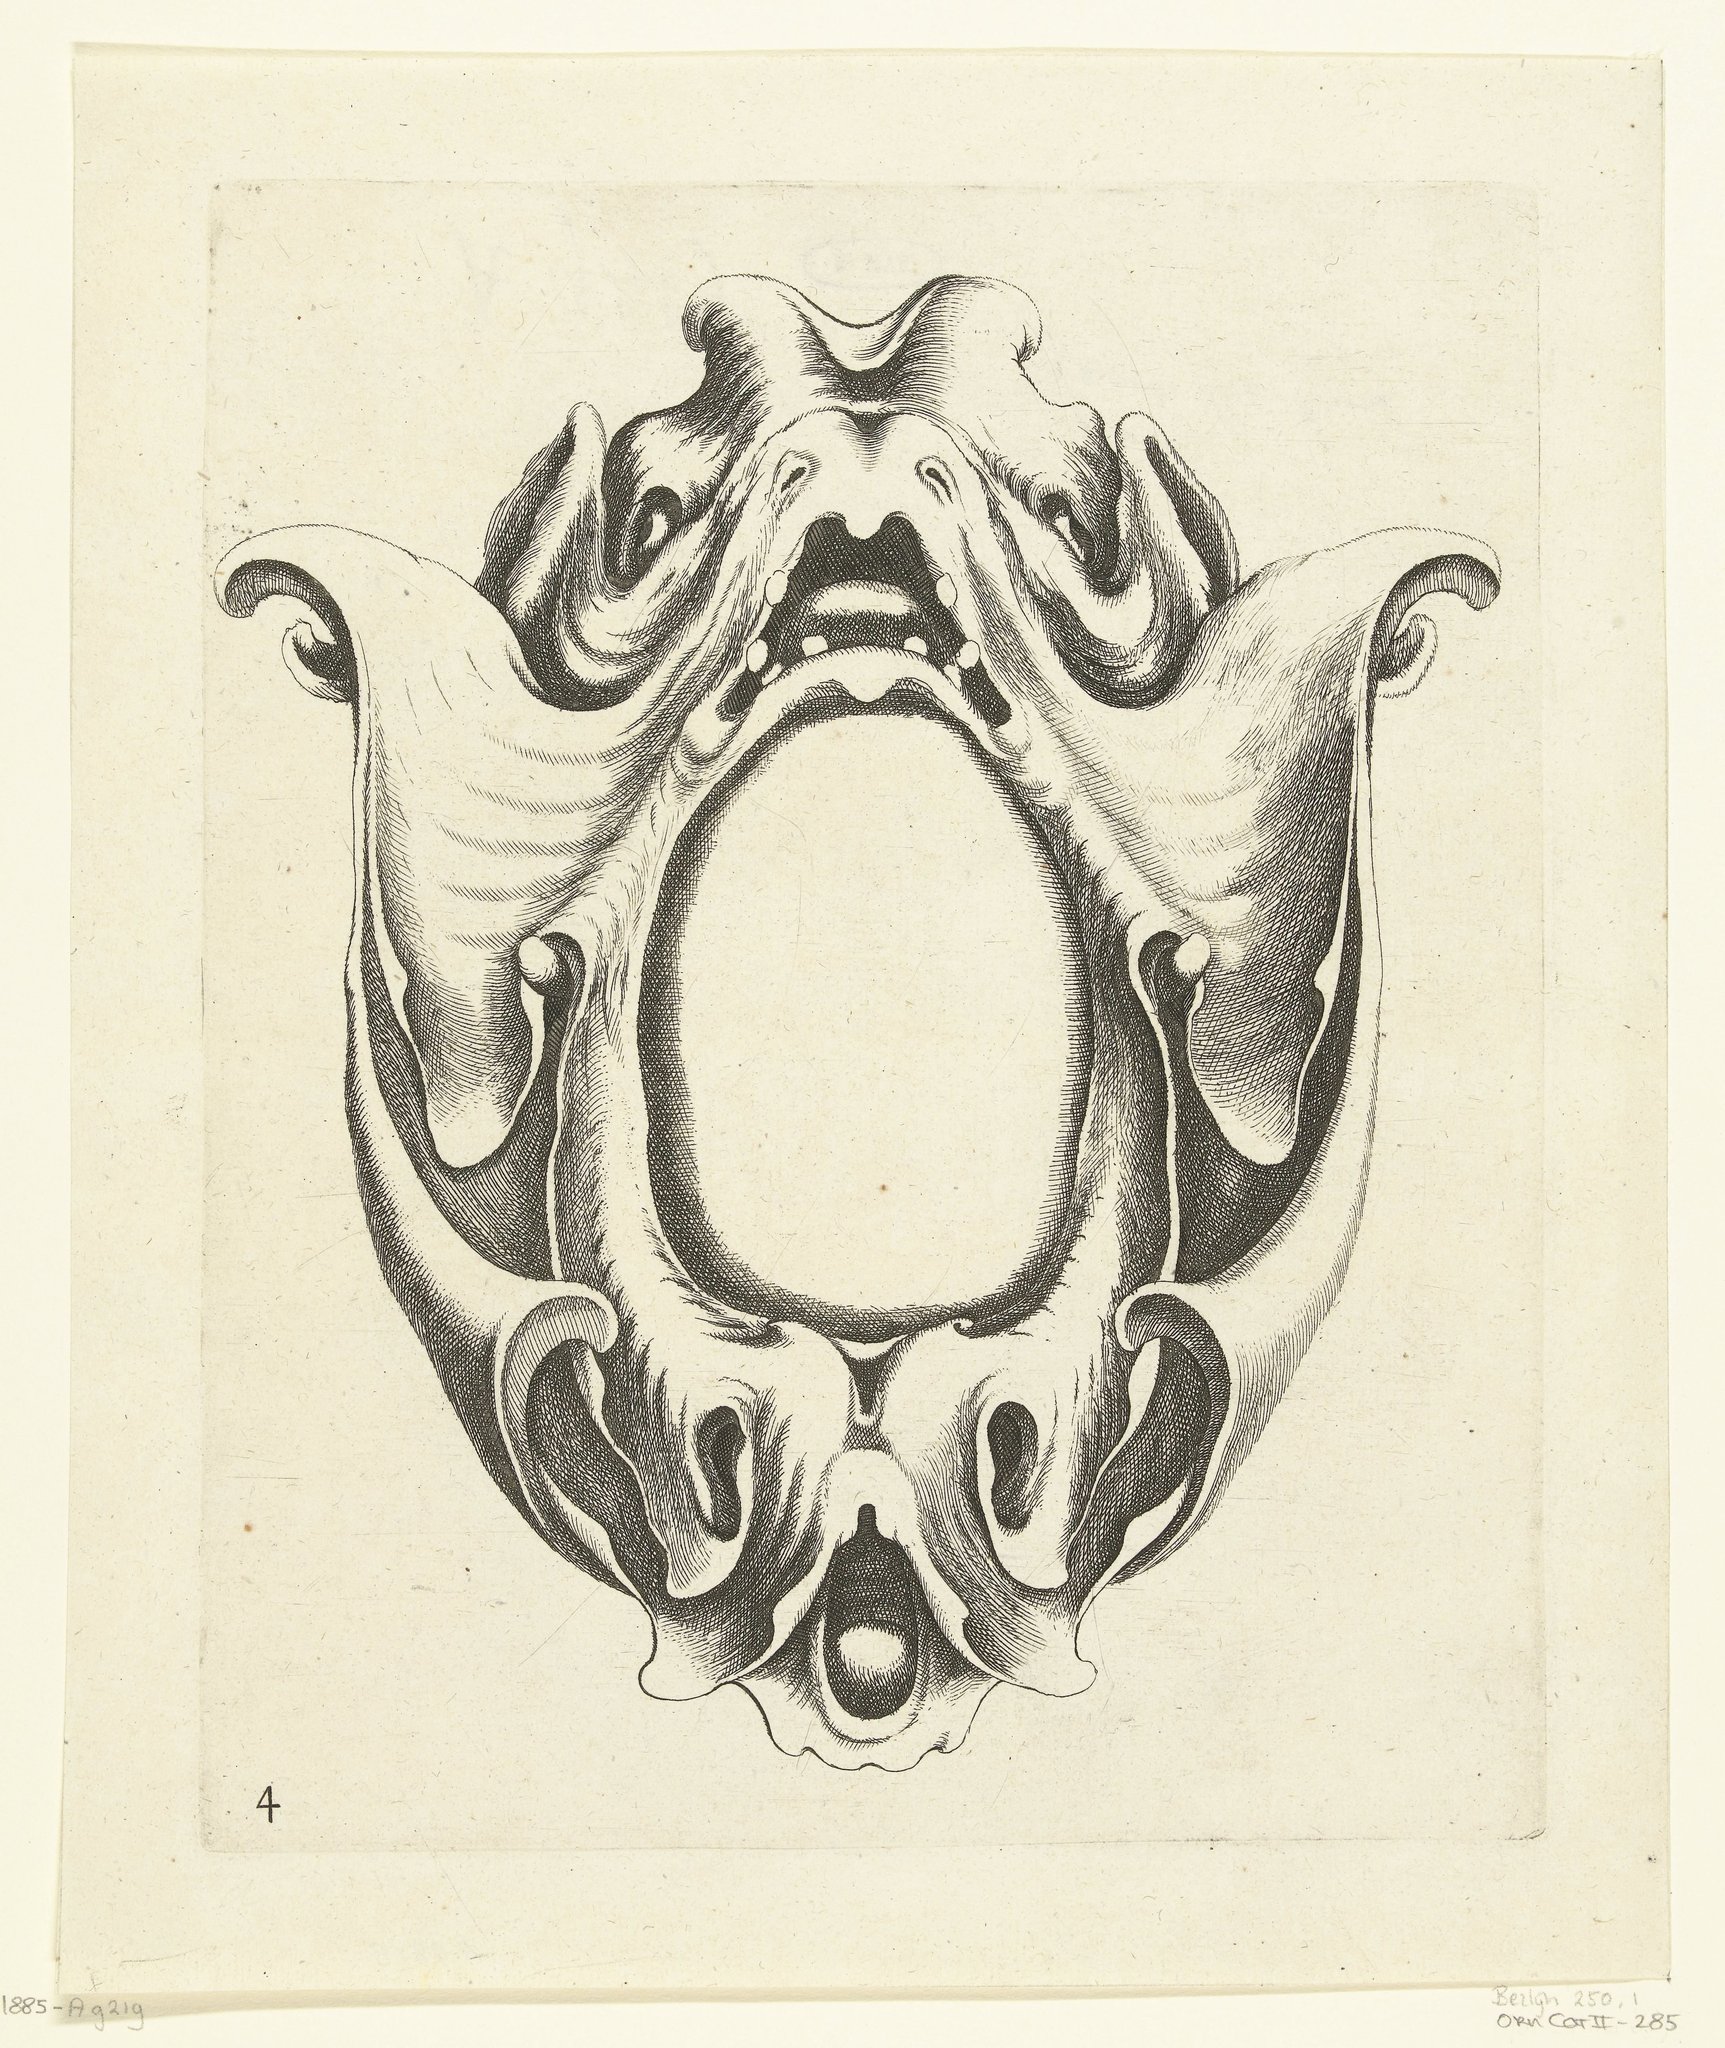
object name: print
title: Veelderhande Nieuwe Compartemente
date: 1654-1678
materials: paper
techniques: etching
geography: amsterdam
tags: ornament ~ cartouche, mask, mascaron ~ ornament